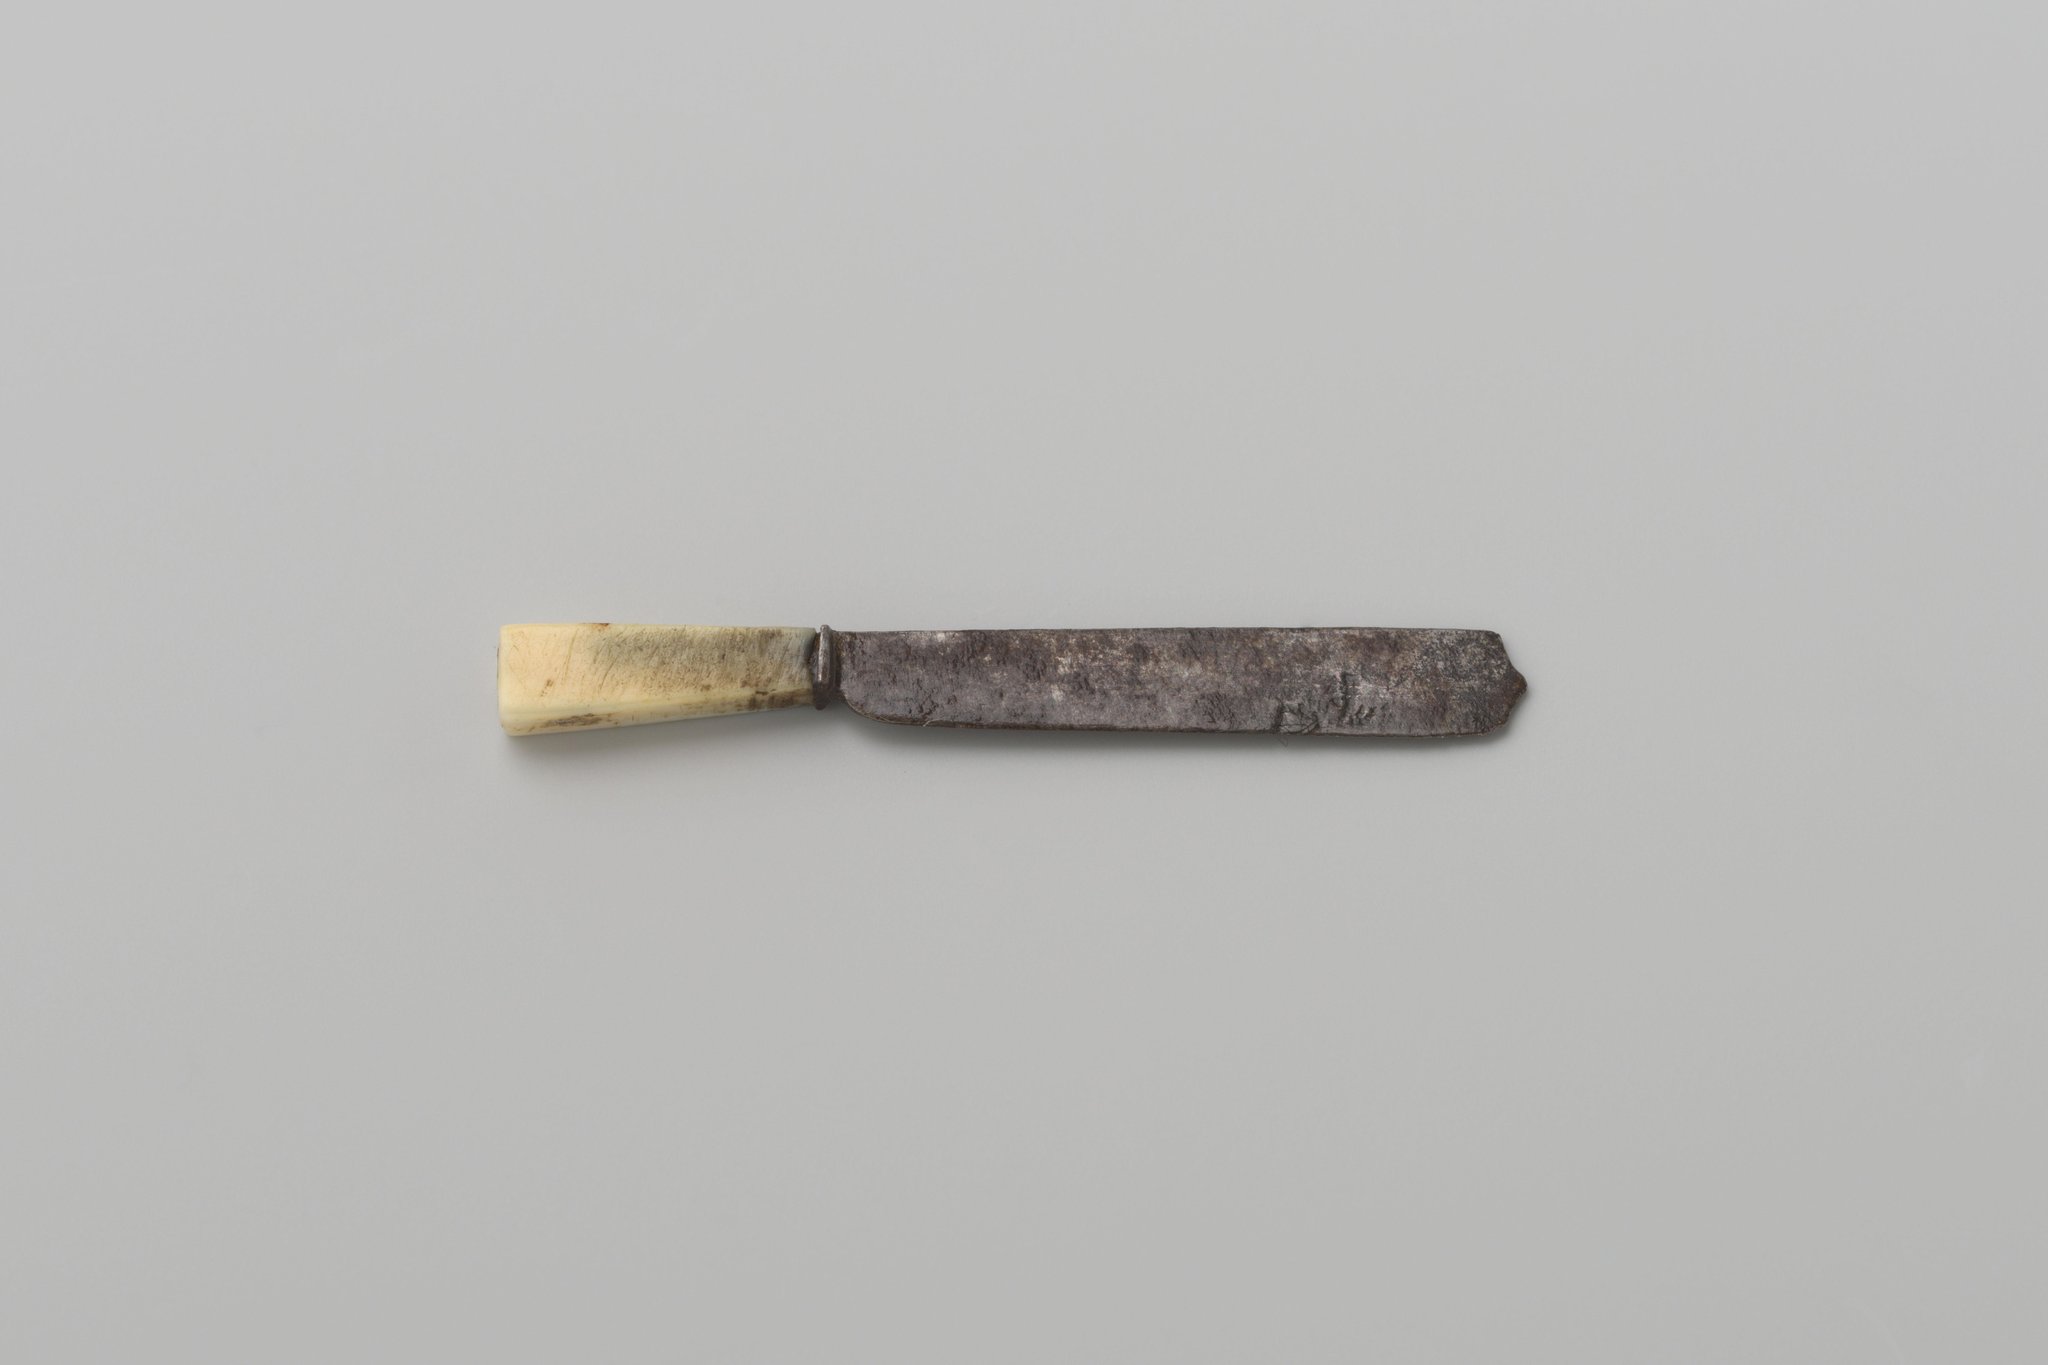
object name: miniature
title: Mes met heft van ivoor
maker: Anonymous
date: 1690-1710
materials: iron, ivory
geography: amsterdam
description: Mes, recht lemmet van zeer plat gesmeed ijzer, eindigend in driehoekige punt, heft van ivoor.